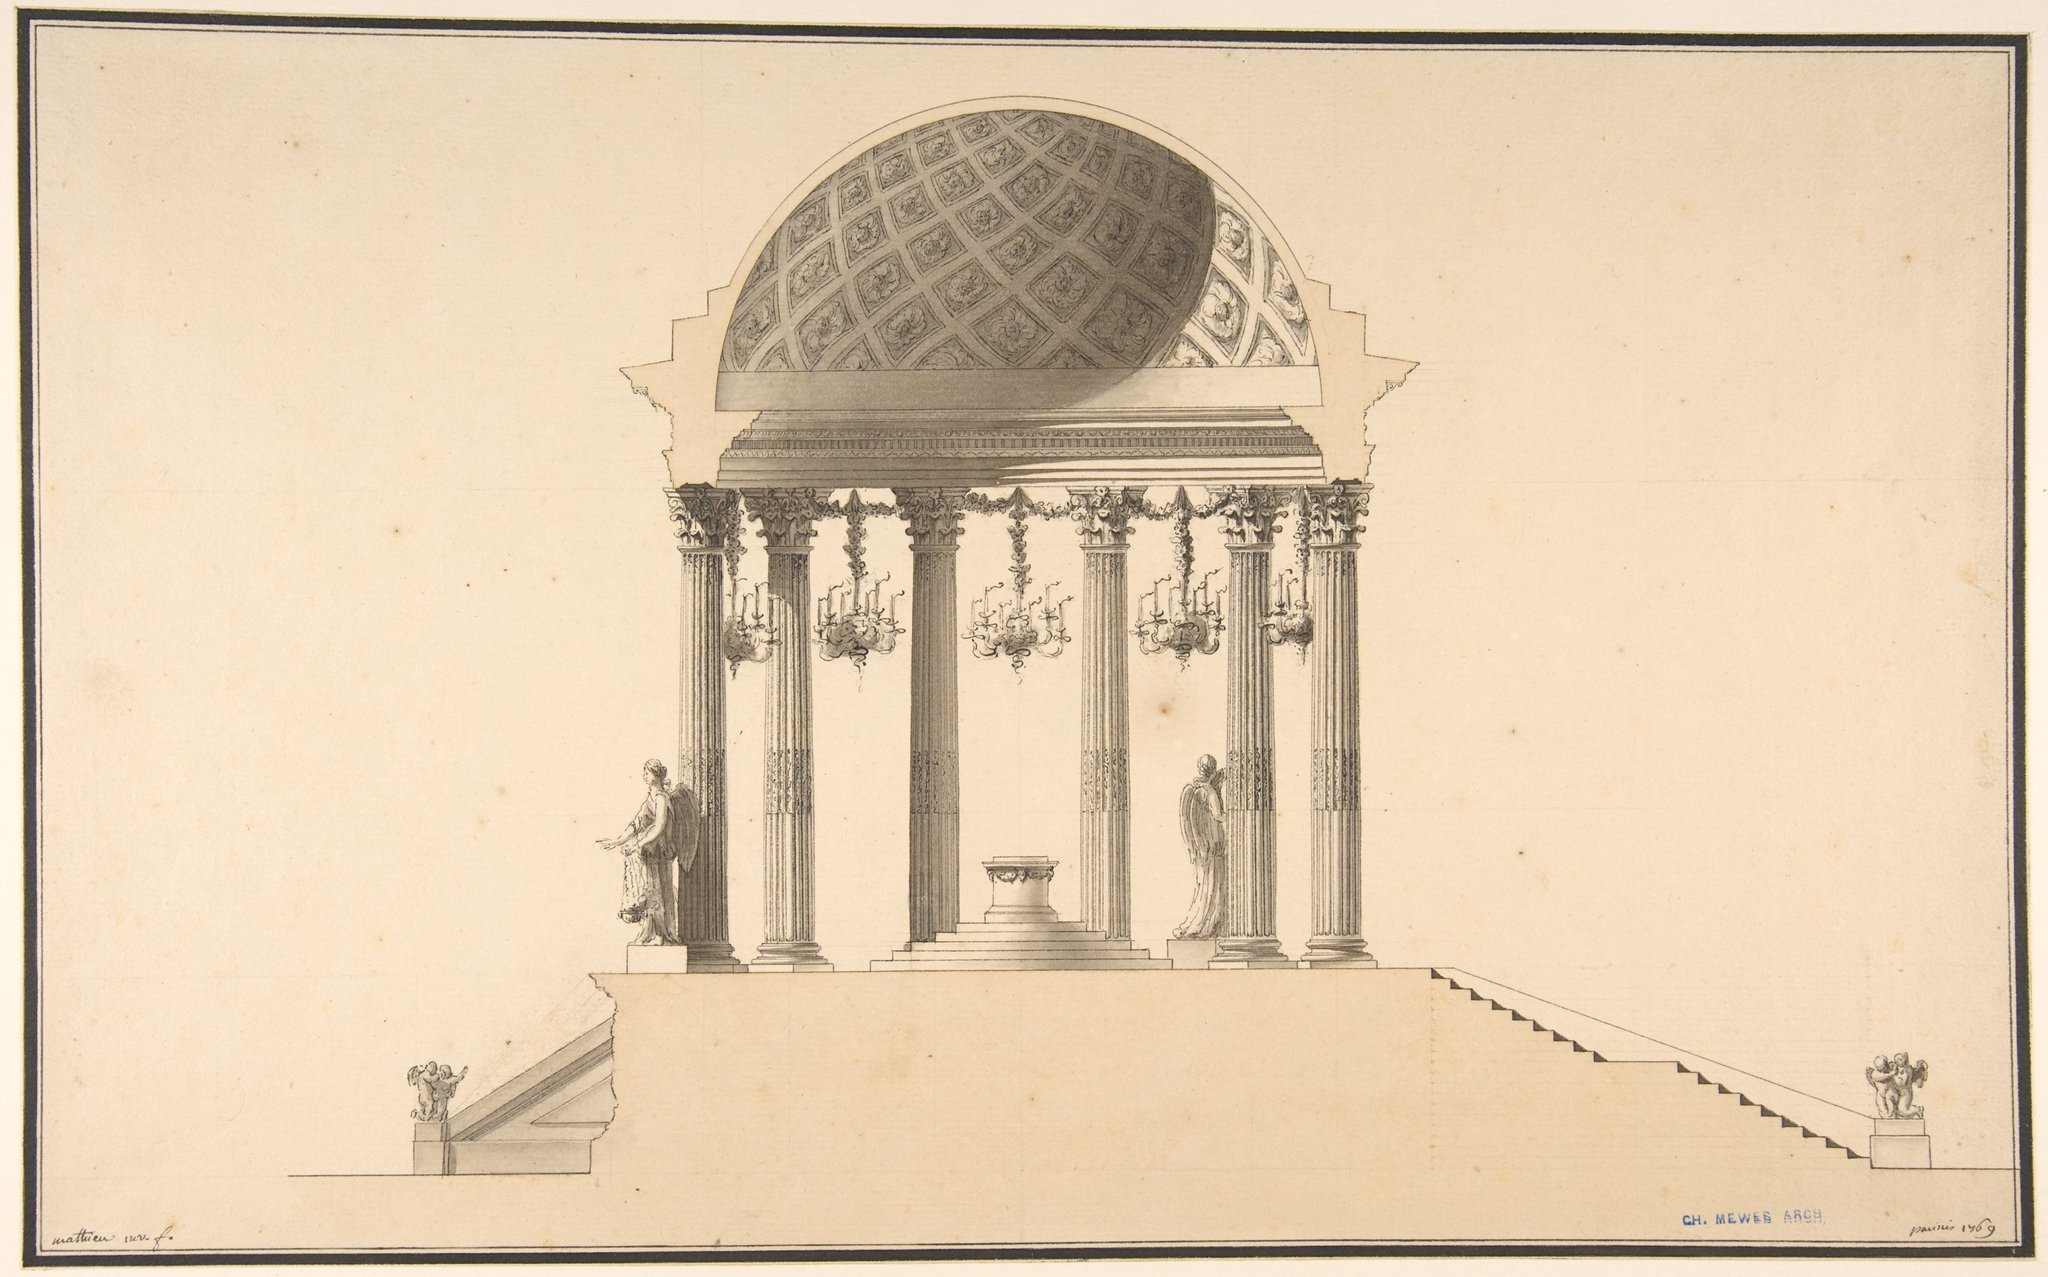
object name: drawing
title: Design for a Section of a Domed Corinthian Temple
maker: pierre mathieu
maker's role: artist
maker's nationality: french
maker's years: 1657-1719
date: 1769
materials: graphite, ink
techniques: brush, pen, wash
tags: architecture,temples